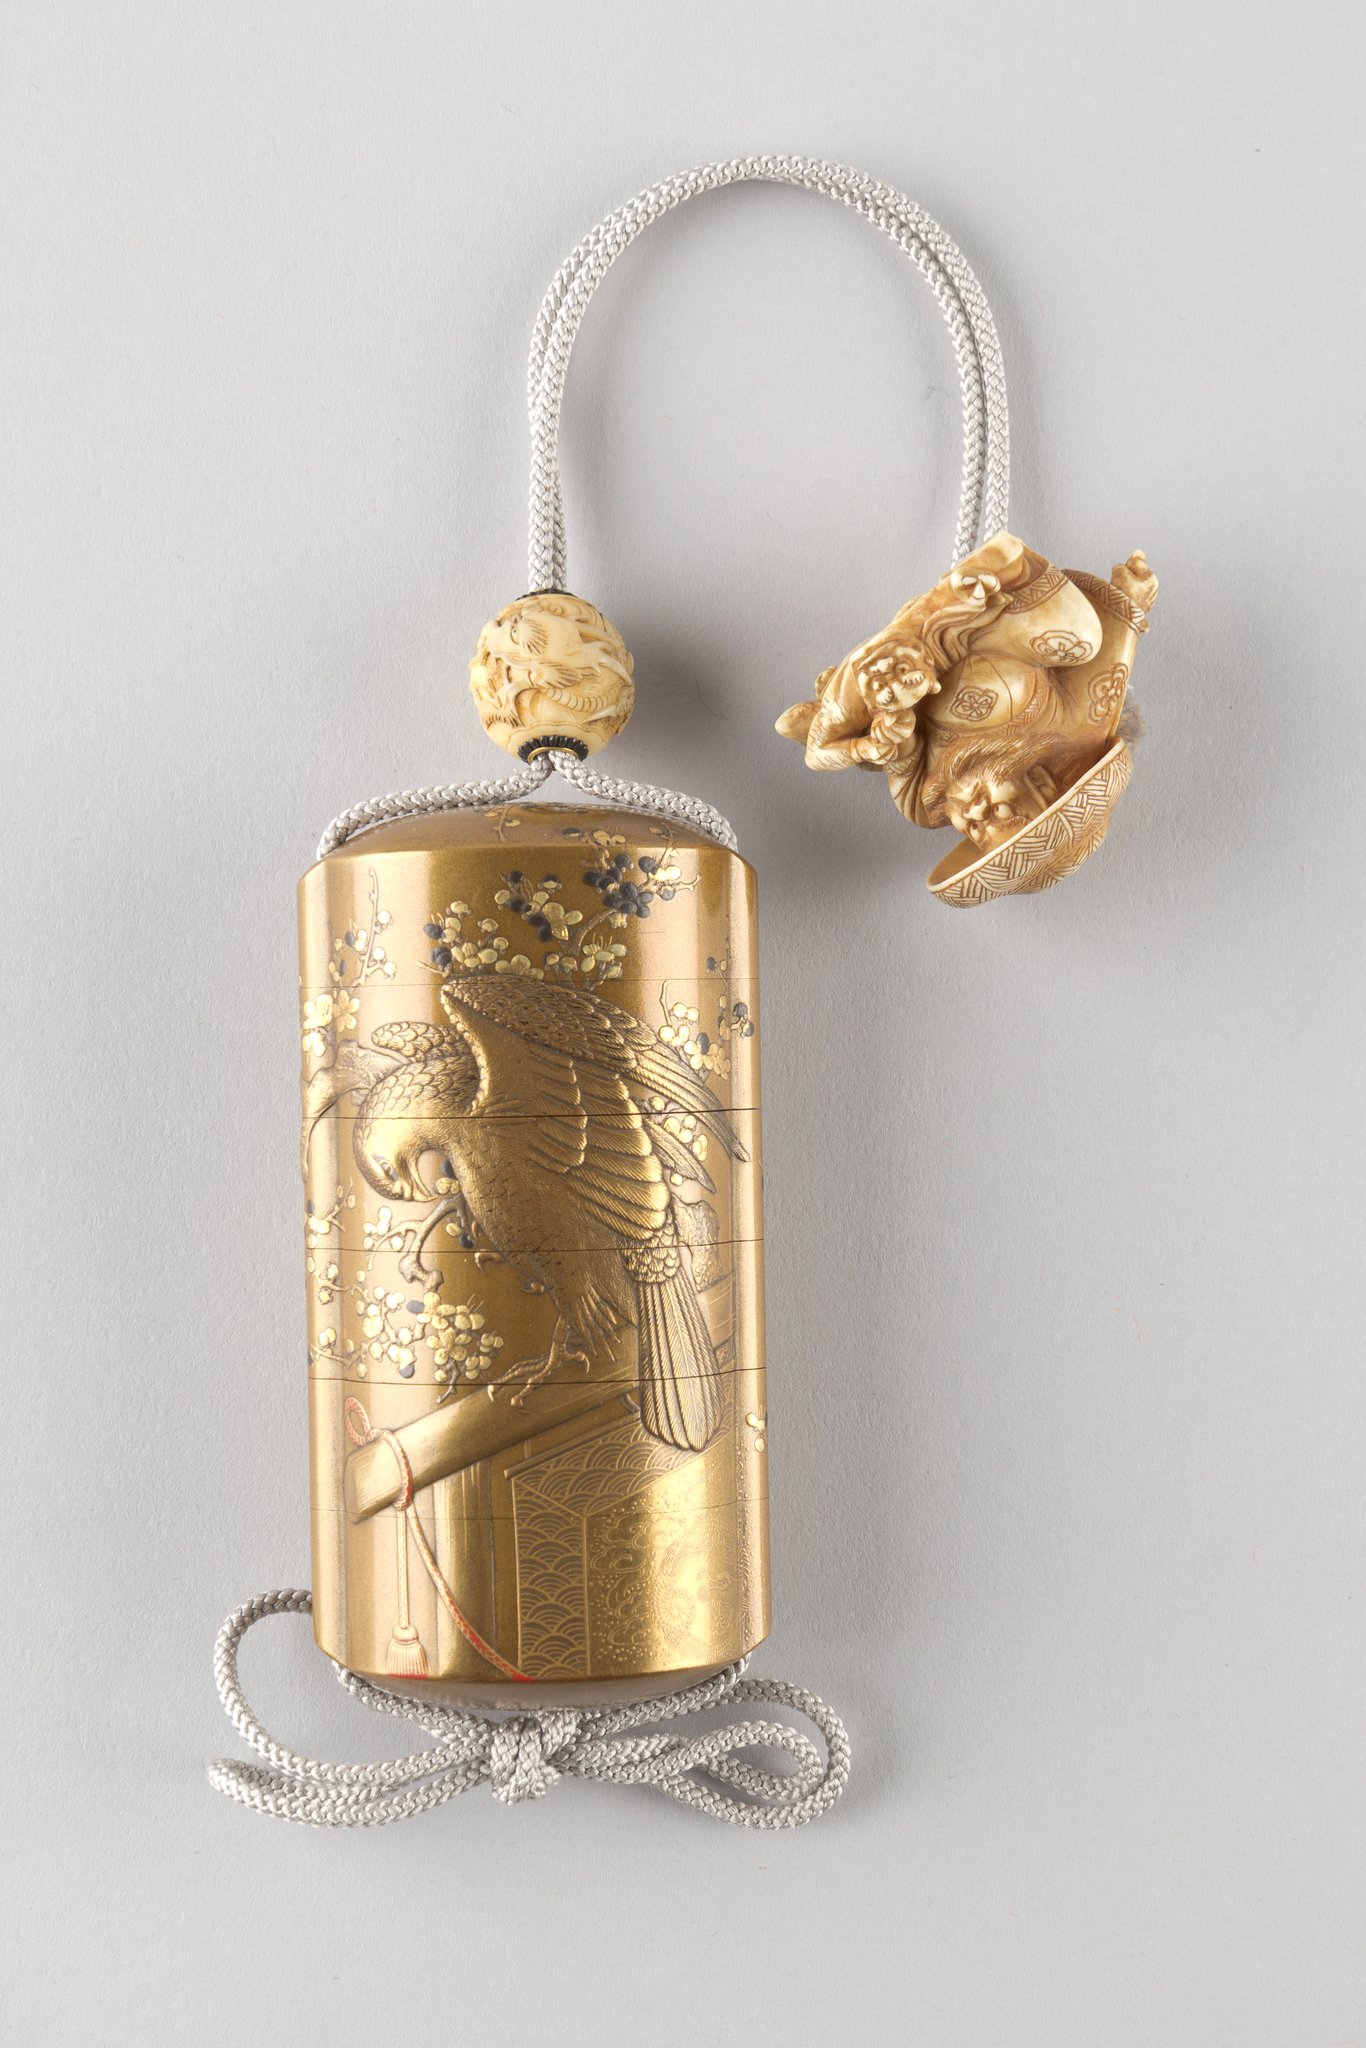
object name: inrō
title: Case (Inrō) with Design of Falcon on Perches and Blossoming Plum Tree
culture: japanese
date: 1801-1900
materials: gold, gold foil, lacquer, silver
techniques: fundame, hiramakie, inlay, maki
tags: falcons